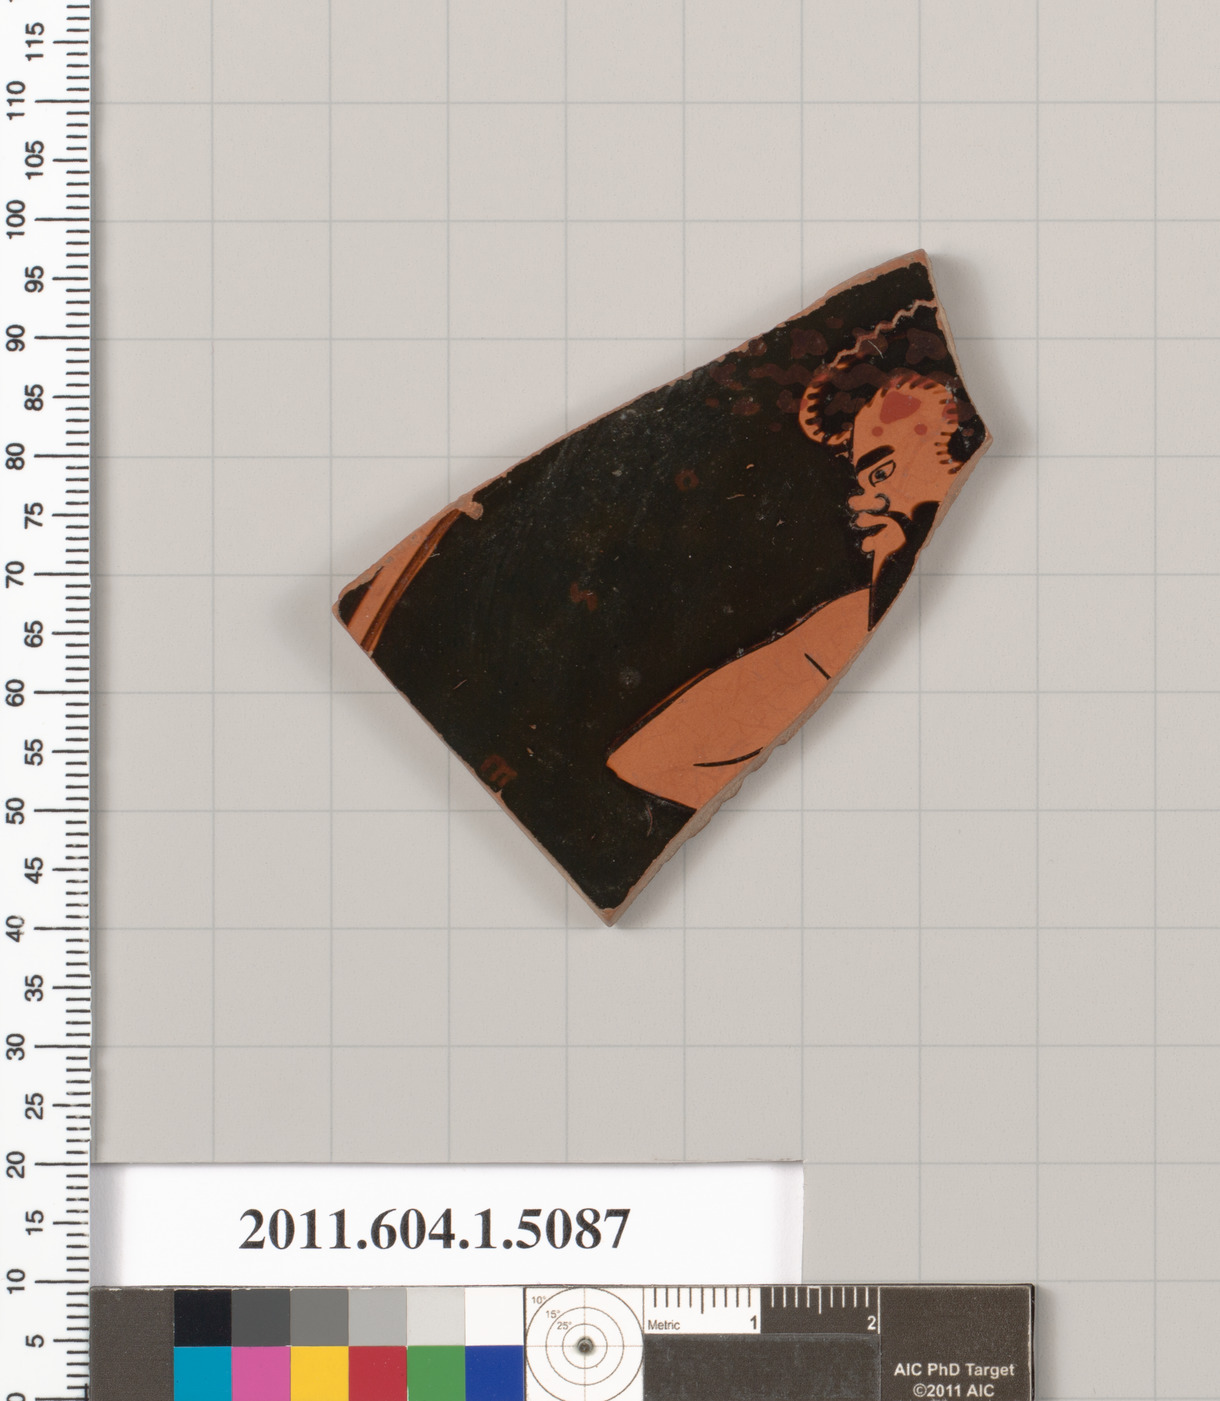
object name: kylix fragment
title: Terracotta fragment of a kylix (drinking cup)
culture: greek, attic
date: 520-500 BCE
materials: terracotta